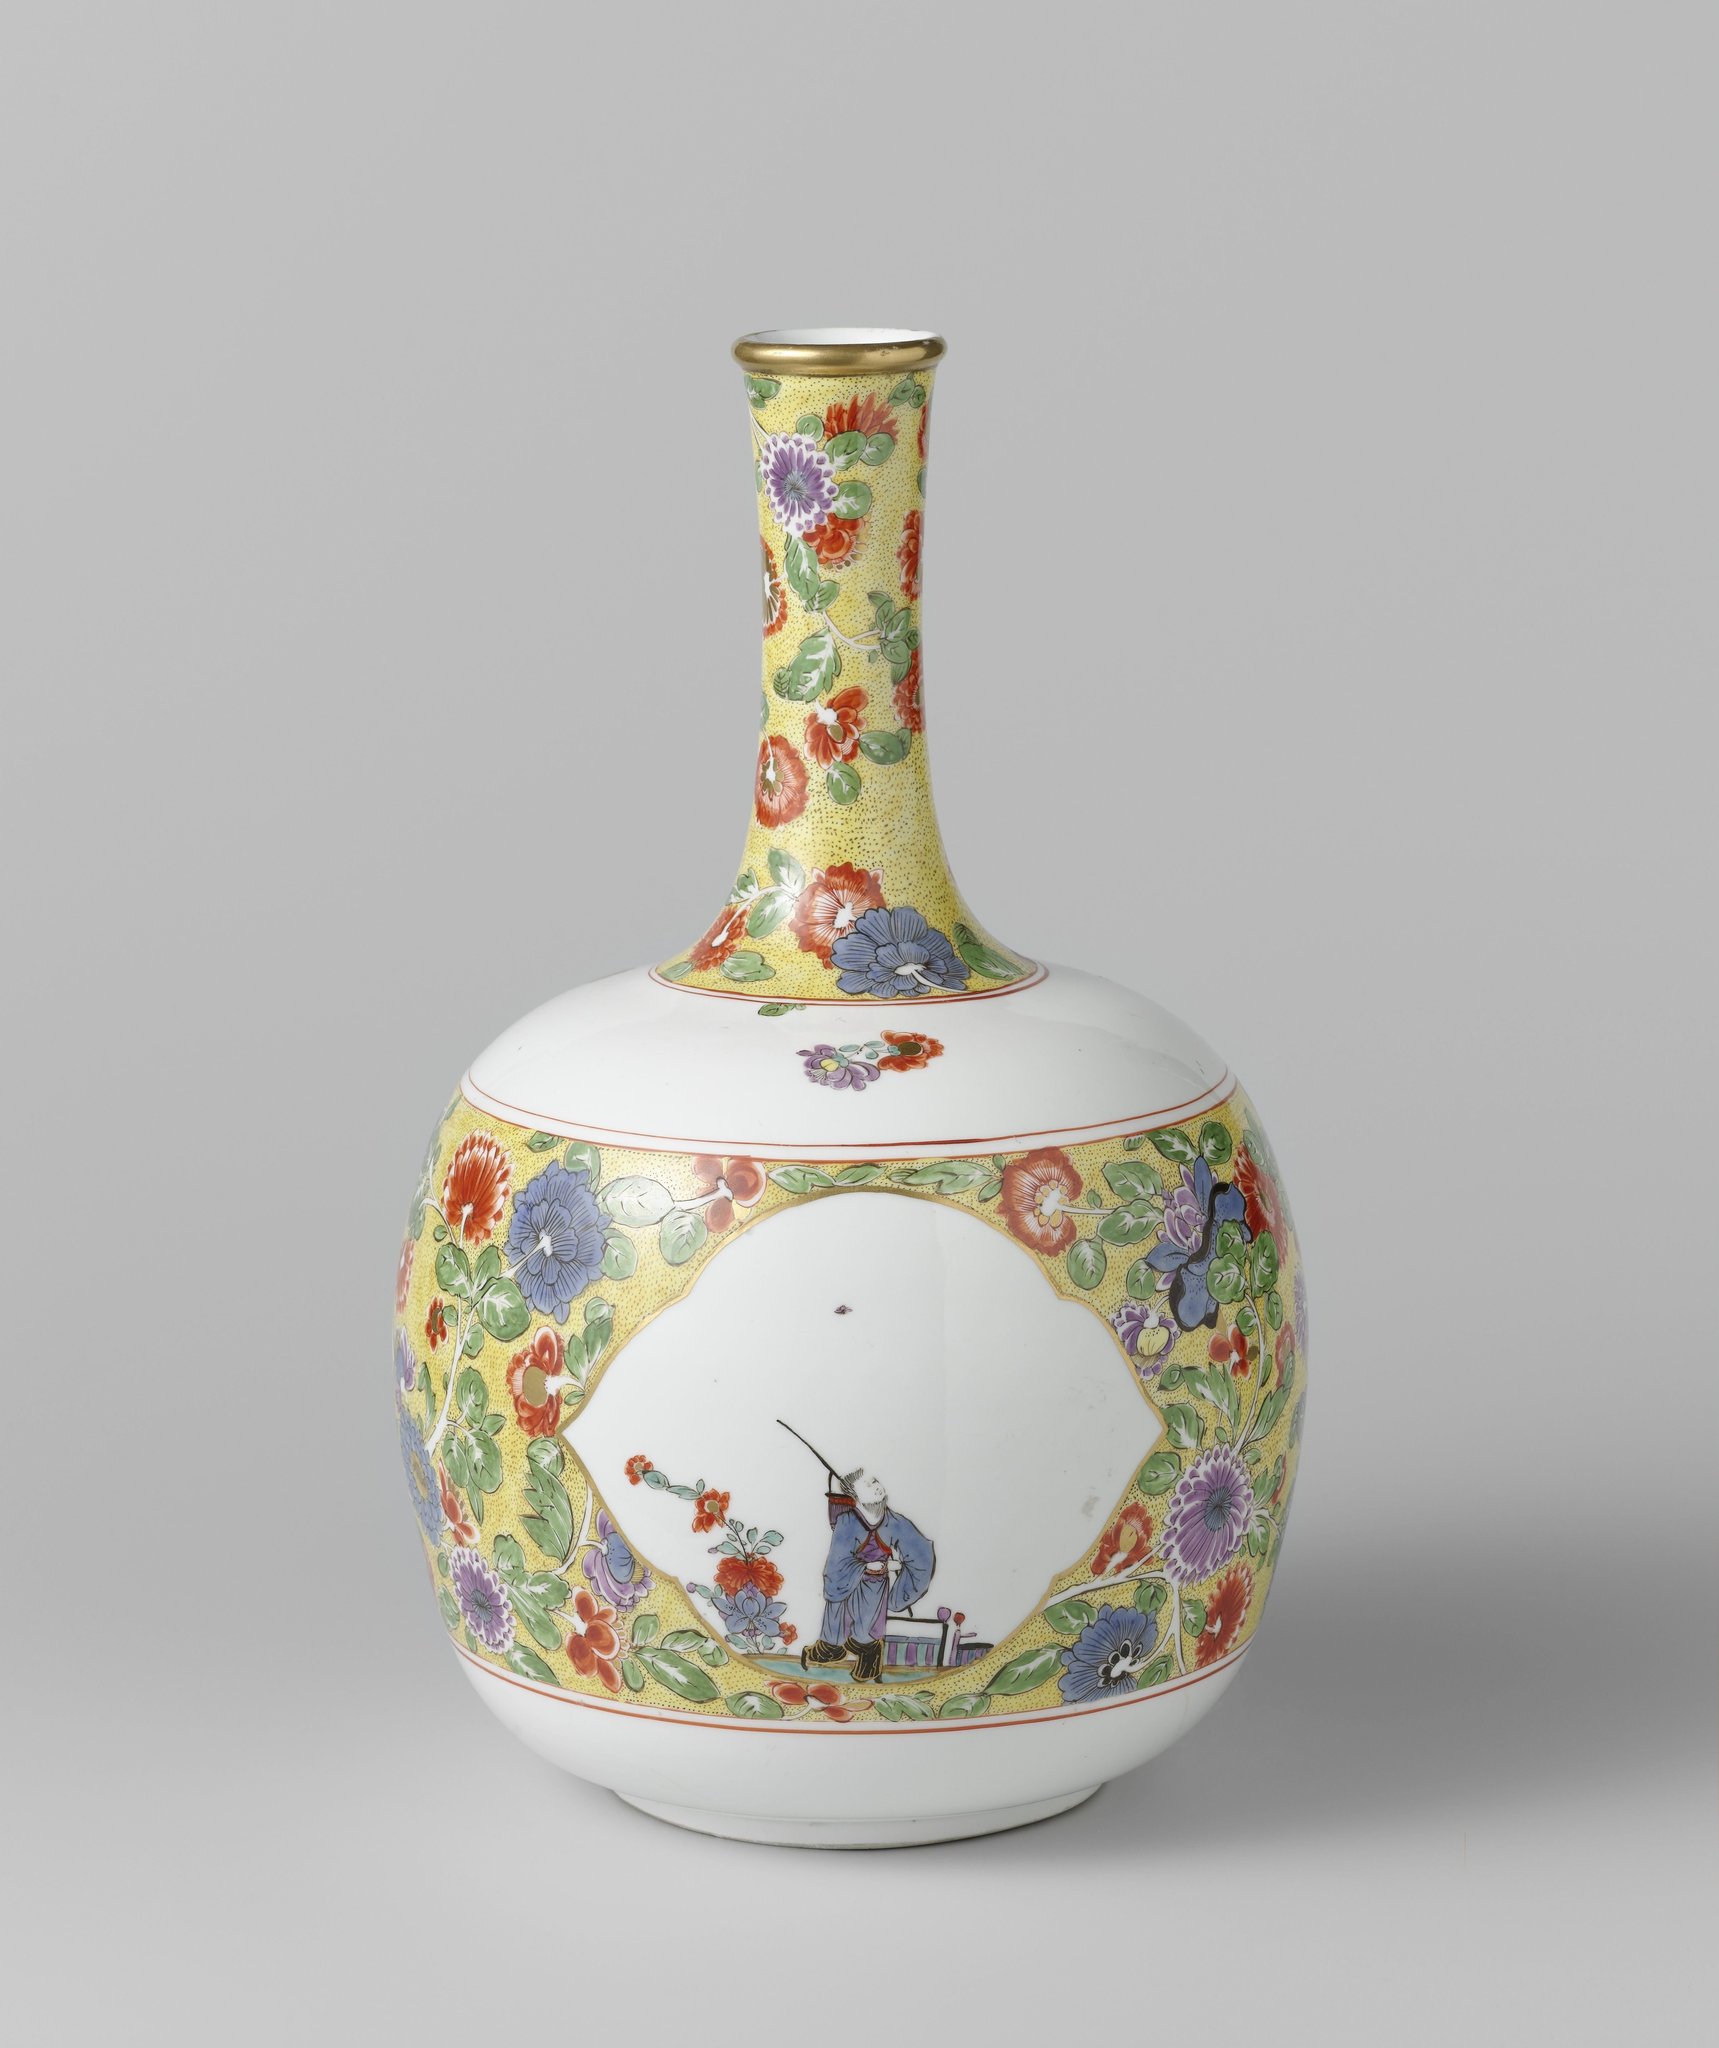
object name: vase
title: Vaas, veelkleurig beschilderd met Chinezen in uitgespaarde vierpassen in een band met Indianische Blumen op een gele fond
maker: johann daniel rehschuh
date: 1730-1735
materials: porcelain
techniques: painted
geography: meissen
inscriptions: mold mark: ‘X (Rückert 1996, afb. 6, nr. 33)’, factory mark: ‘AR’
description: Two vases. Porcelain. Meissen, c. 1730 - 1735.